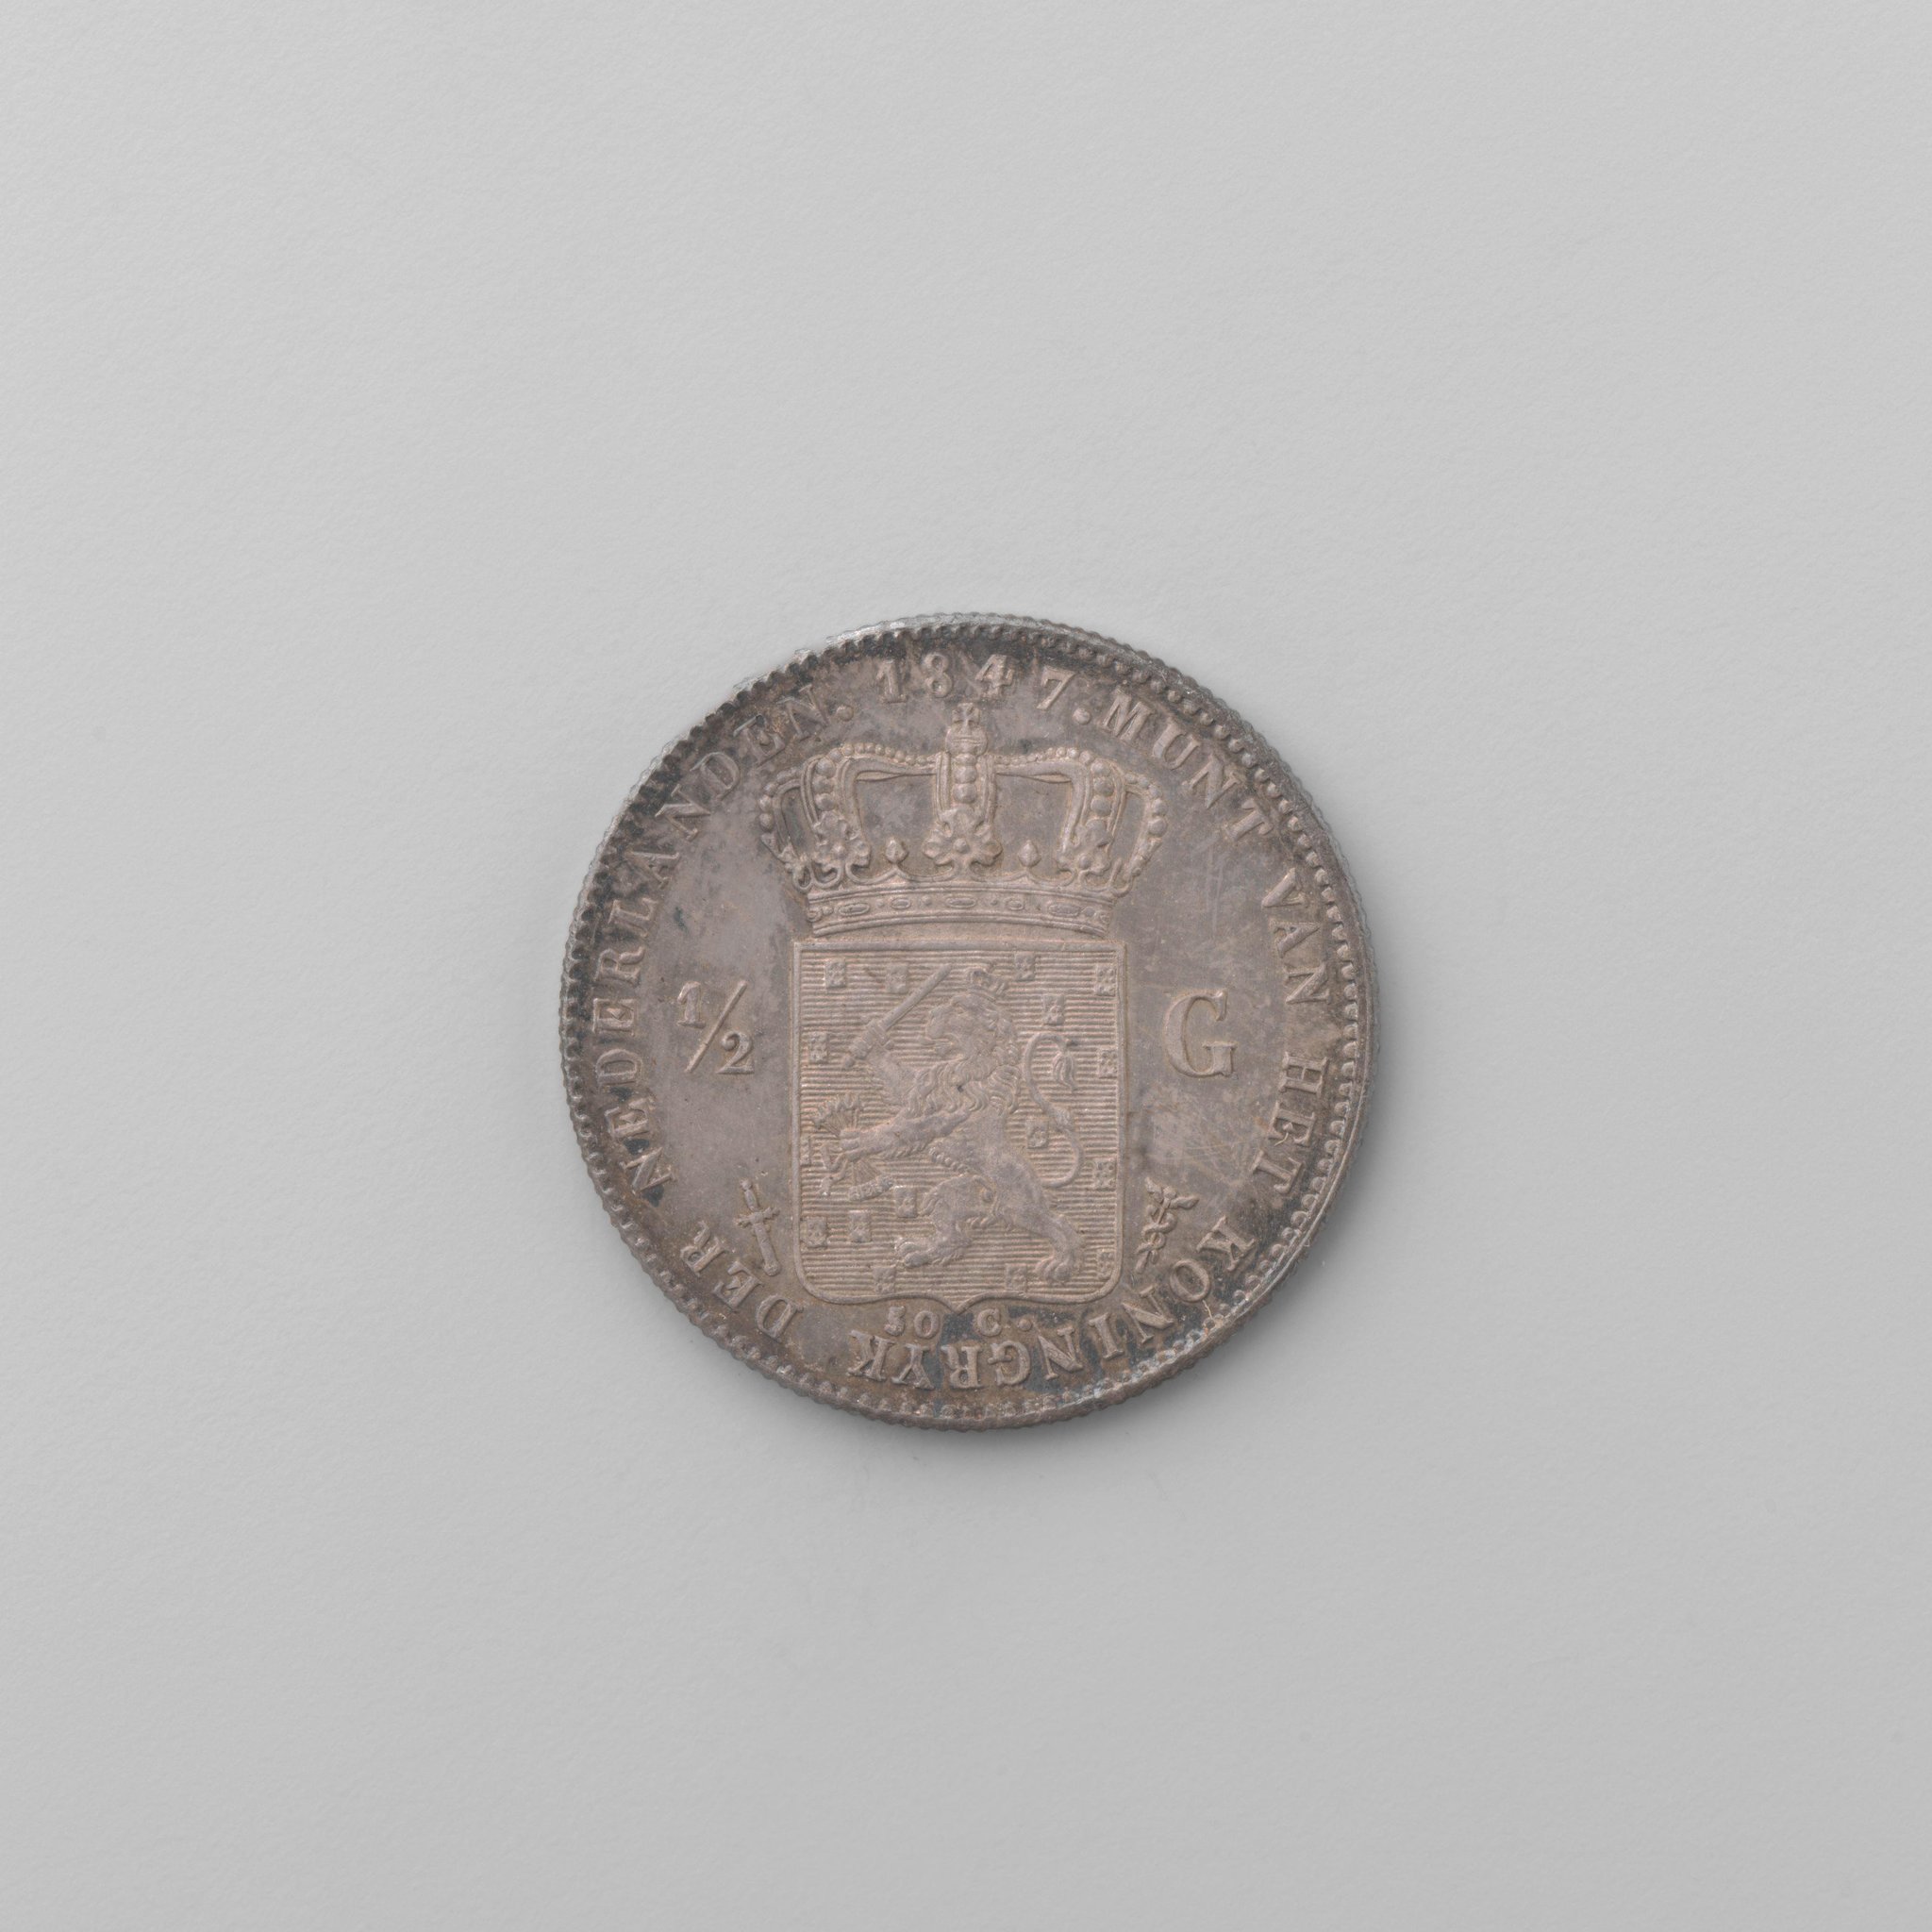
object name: coin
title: Nederland, ½ gulden, 1847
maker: william ii of the netherlands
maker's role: koning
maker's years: 1792-1849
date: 1847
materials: silver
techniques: striking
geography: utrecht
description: Zilveren munt. Voorzijde: borstbeeld naar links. Keerzijde: tussen waarde-aanduiding ½ G gekroond rijkswapenschild. Jaartal boven kroon. Kartelrand.